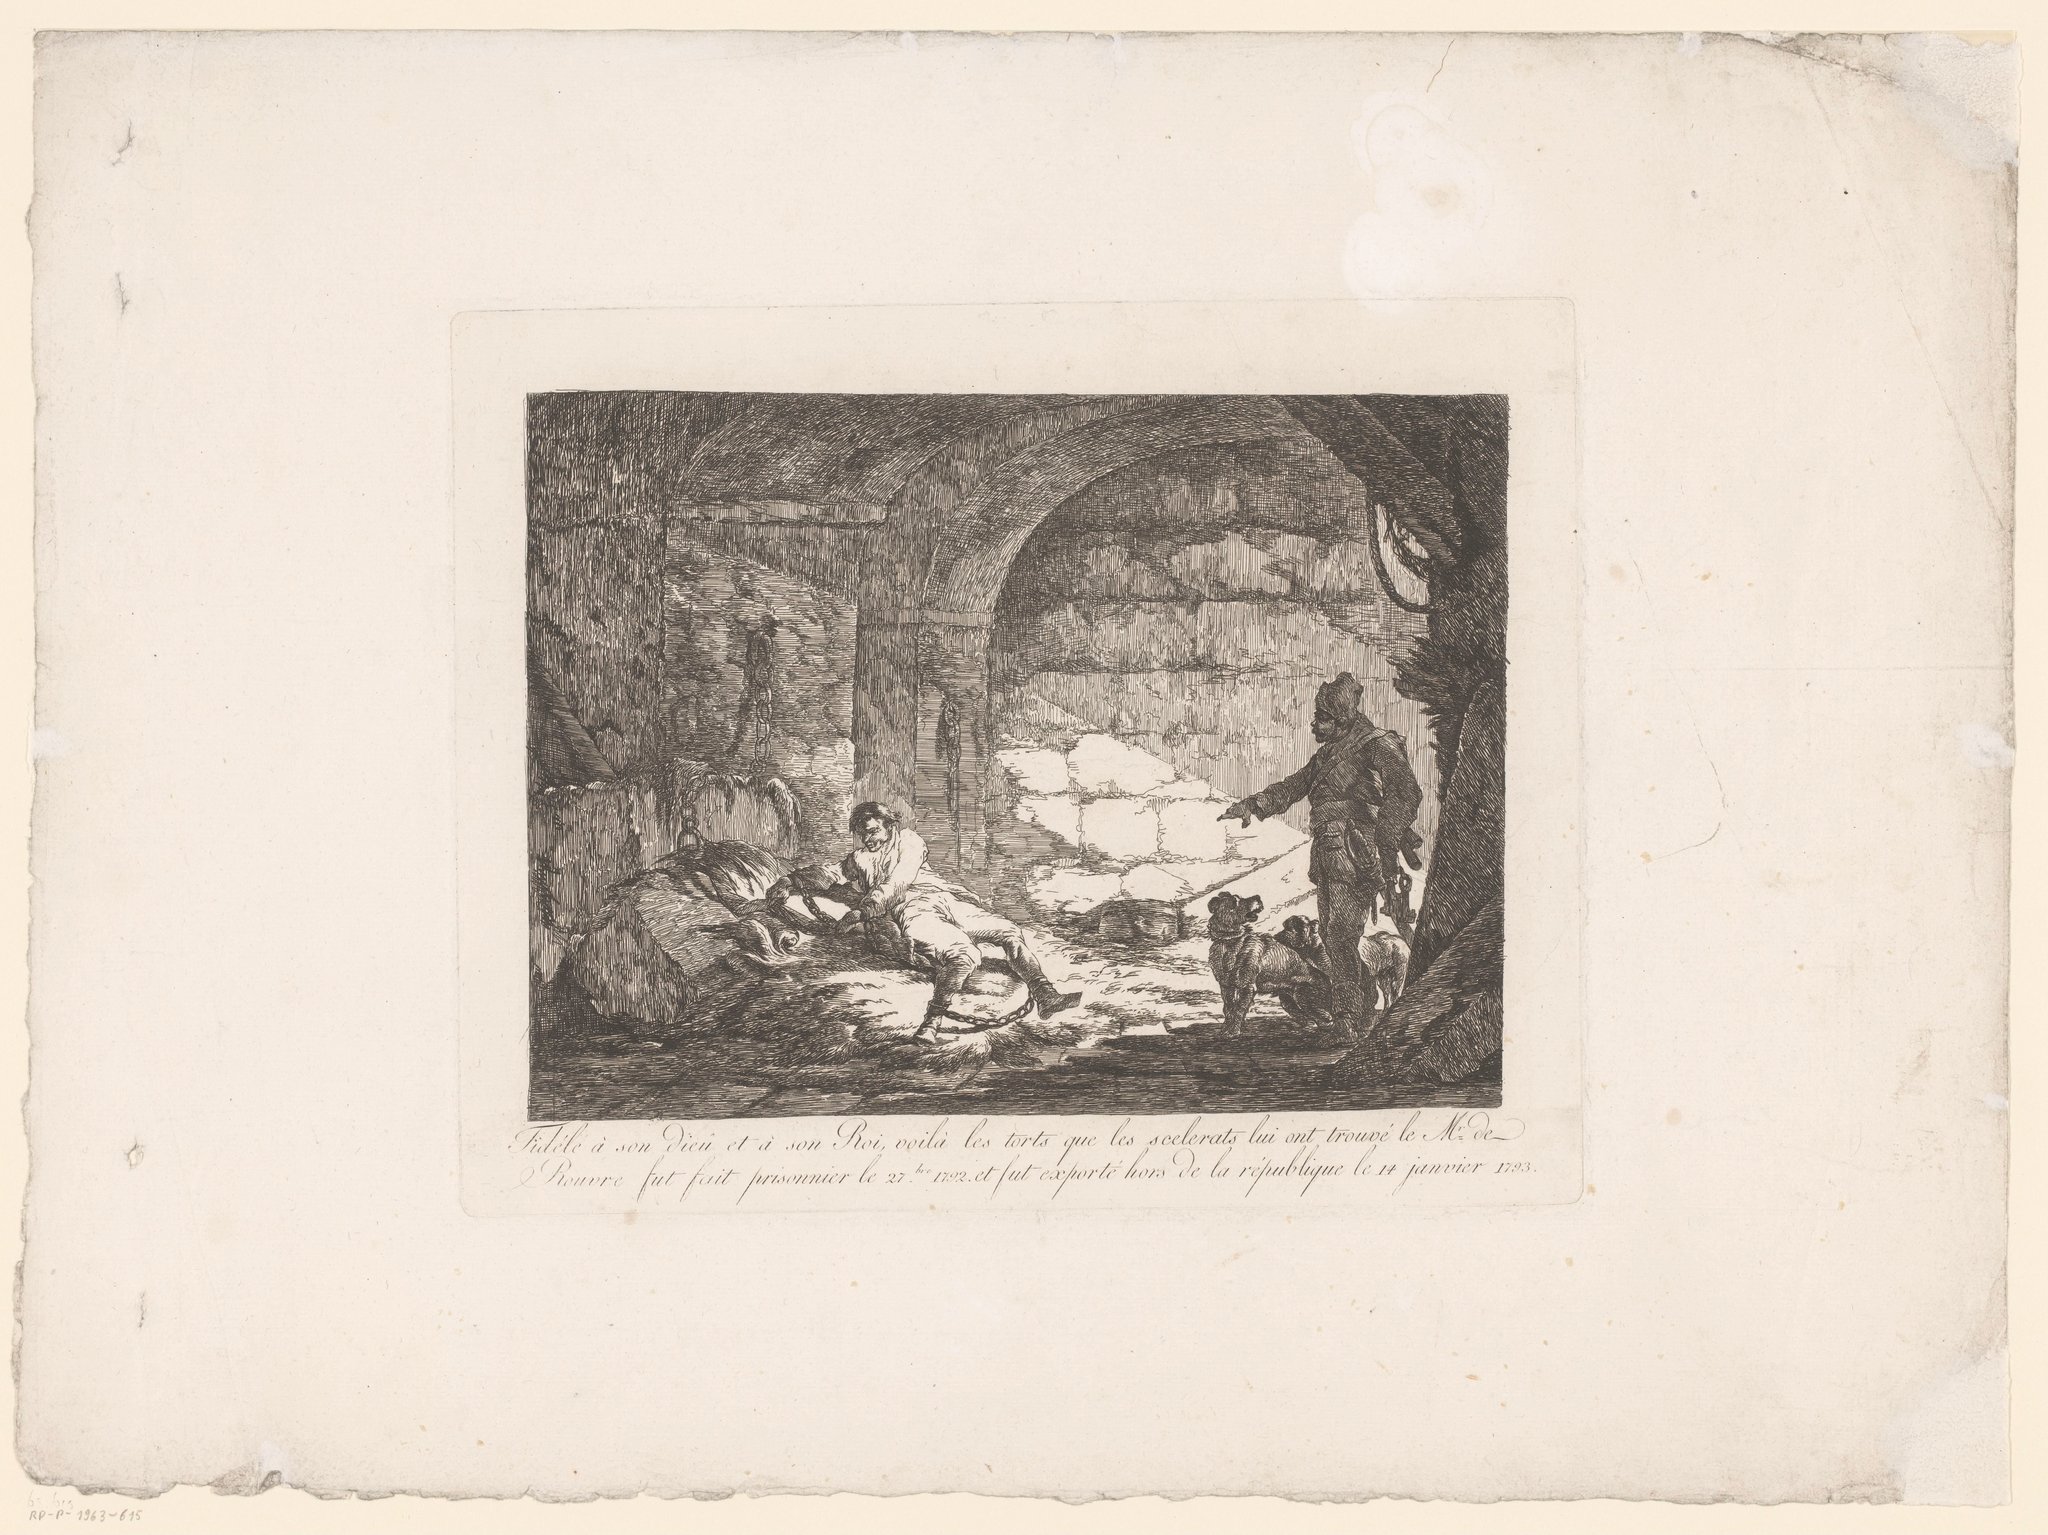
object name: print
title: Prenten naar schilderijen van Ignace Duvivier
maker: Anonymous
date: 1793-1832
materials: paper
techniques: drypoint, etching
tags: prison, jail, watch-dog, dog watching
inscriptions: collector's mark: Lugt 2760, collector's mark: Lugt 2228